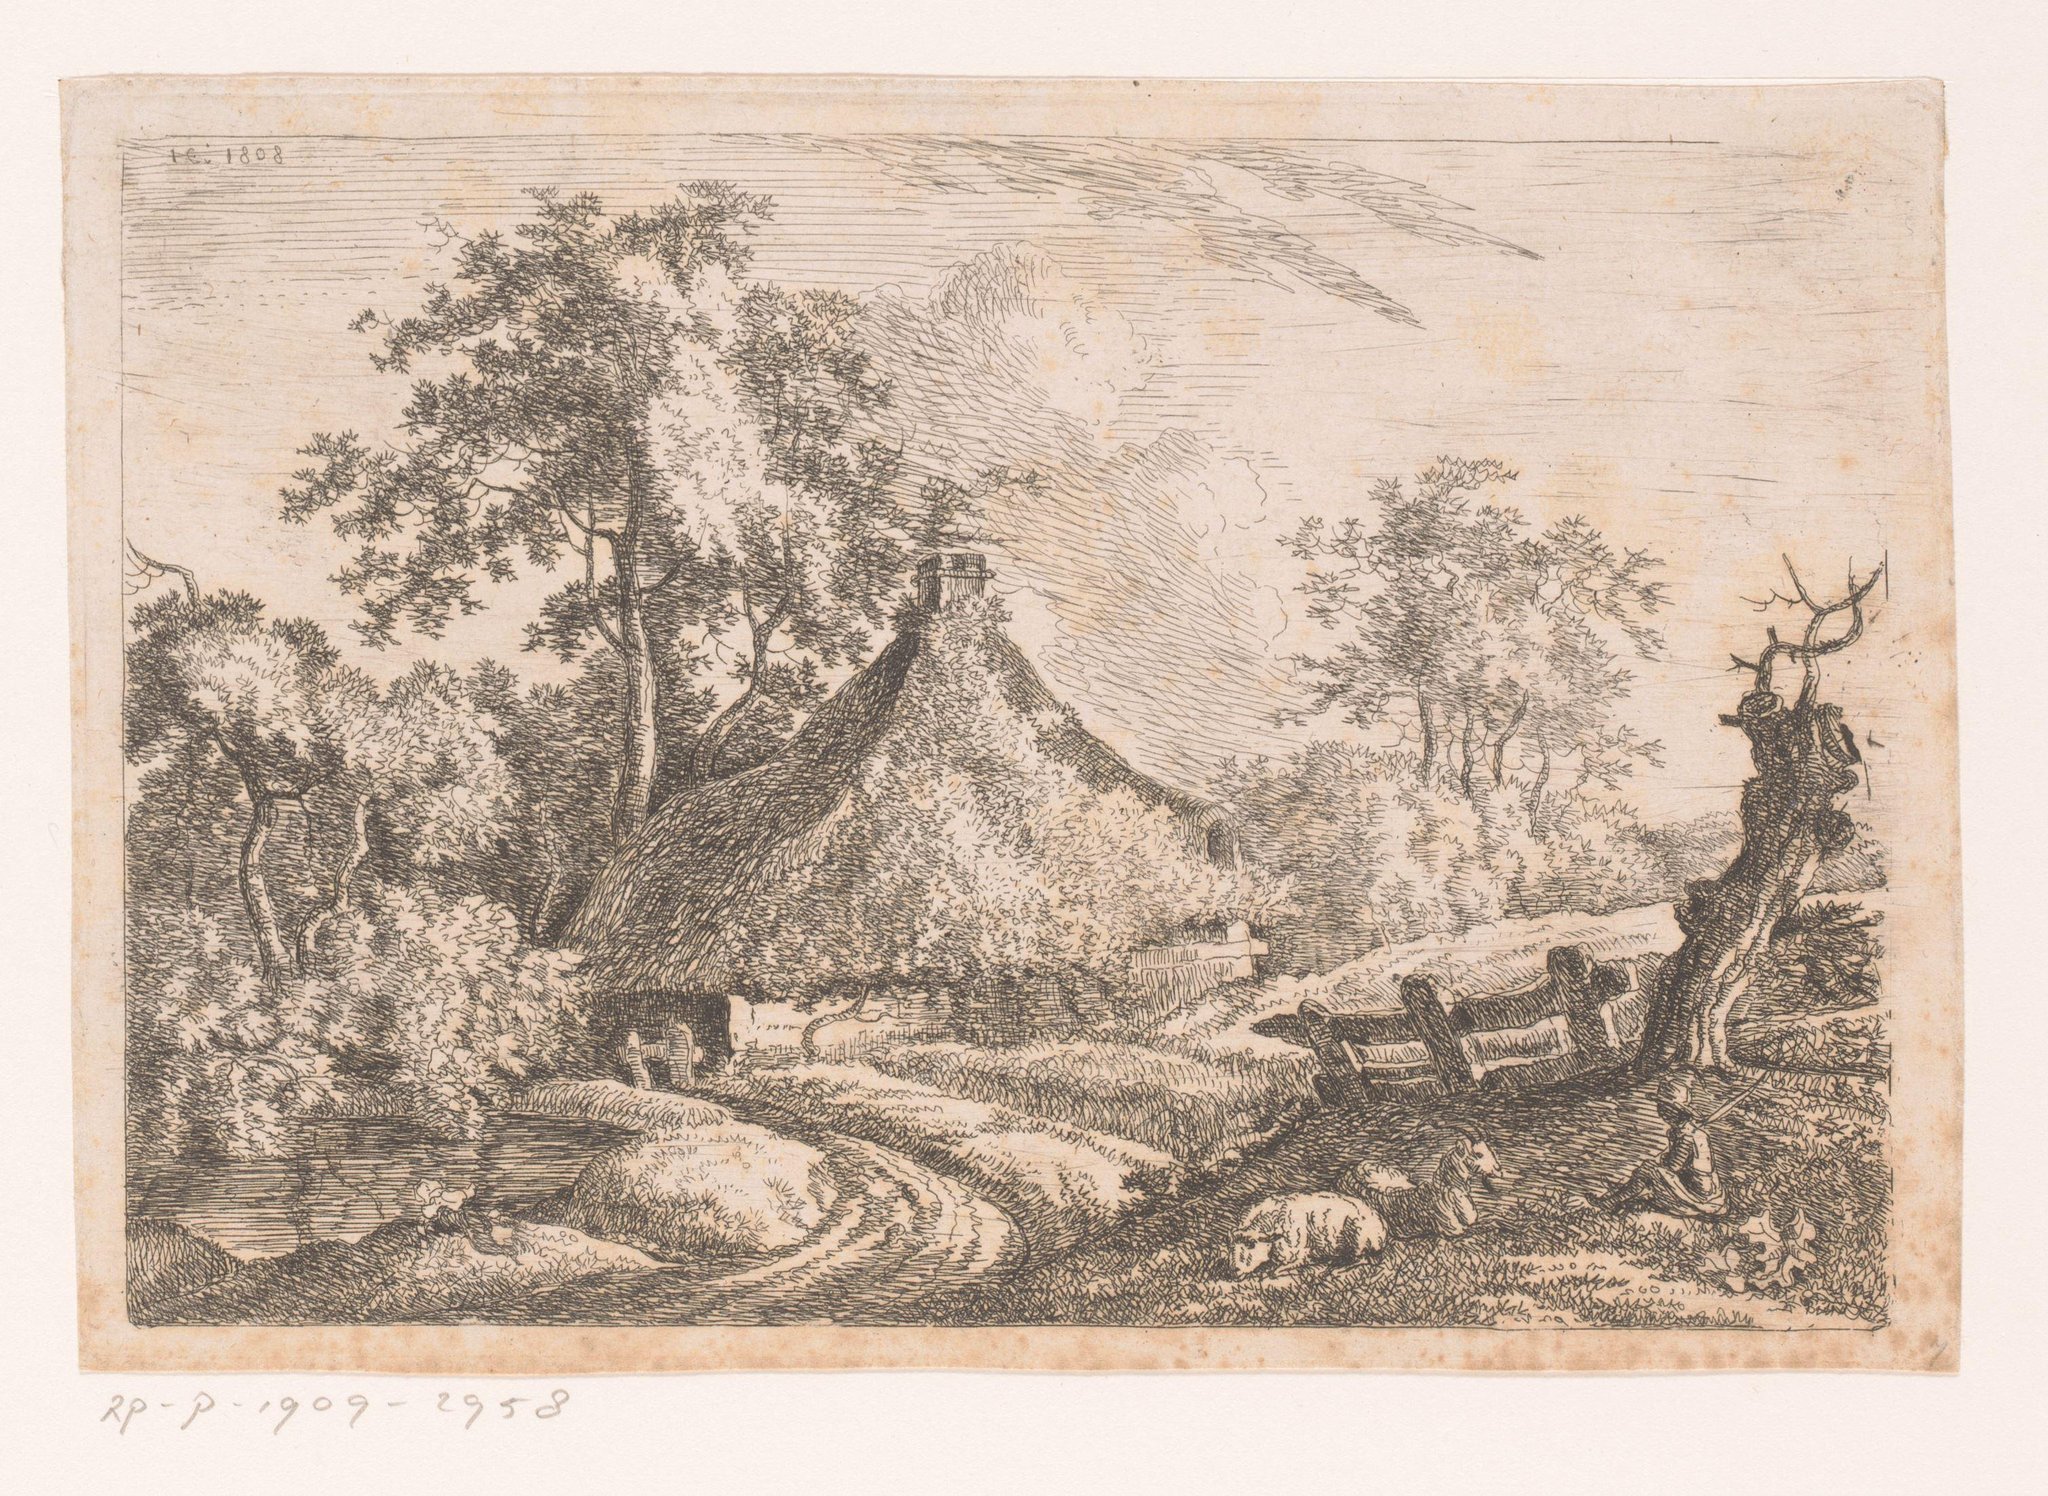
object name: print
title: Landschap met boerderij en weide met vee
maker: joseph charles cogels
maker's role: print maker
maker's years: 1785-1831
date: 1808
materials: paper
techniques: etching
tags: cattle, farm or solitary house in landscape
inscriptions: inscription: ‘Cabane aux environs de Termonde en Flandre’ Lugt, collector's mark: Lugt 2228, collector's mark: Lugt 1485